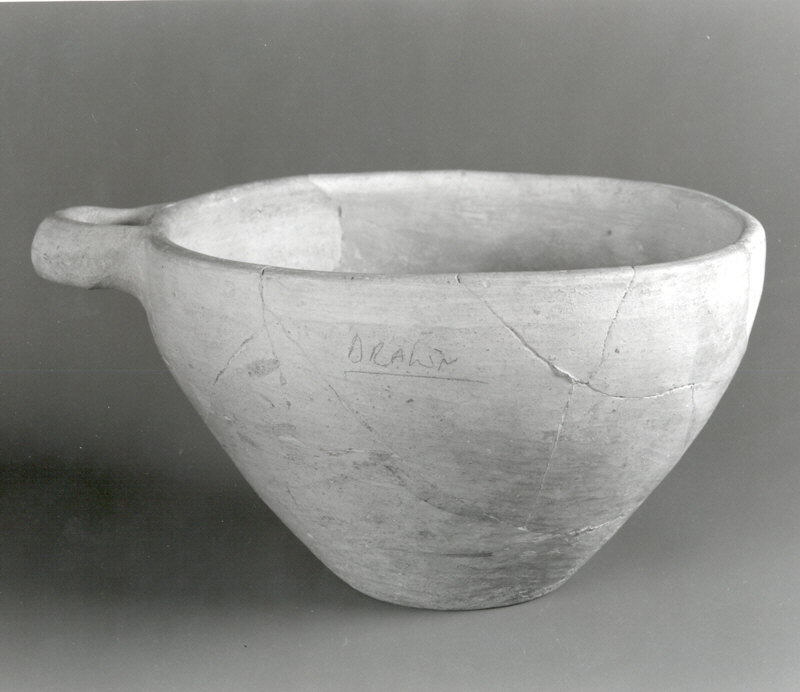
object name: bowl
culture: iranian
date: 700-601 BCE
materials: ceramic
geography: iran